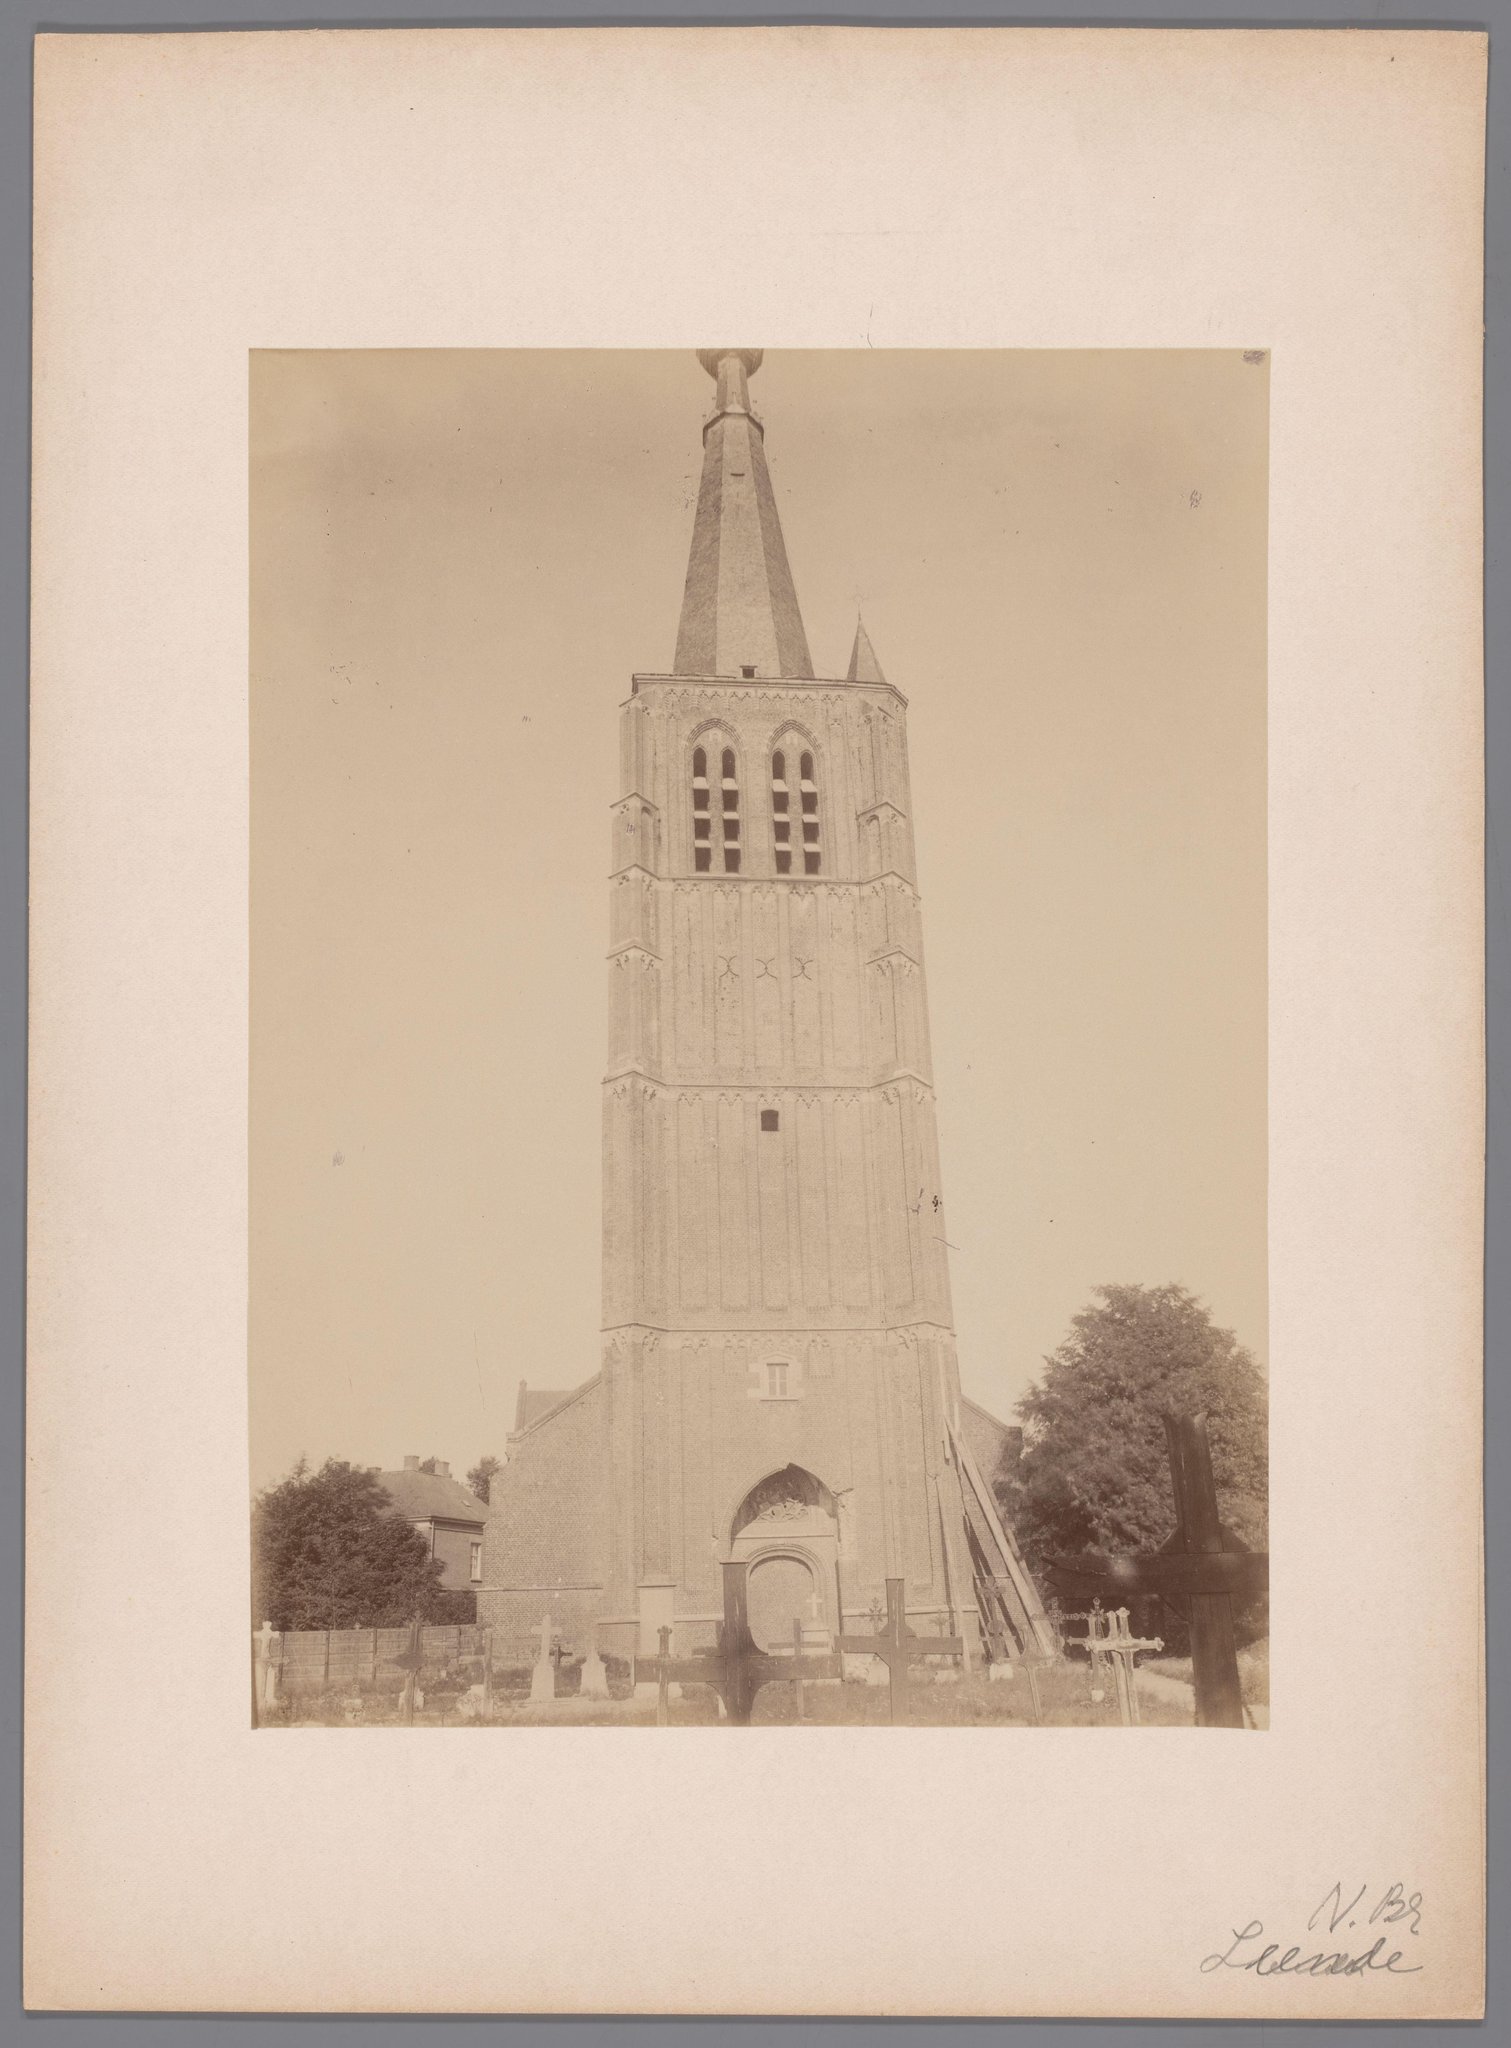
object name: photograph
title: Gezicht op de toren en de begraafplaats van de Sint-Petrus'-Bandenkerk te Leende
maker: anoniem (monumentenzorg)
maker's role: fotograaf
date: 1904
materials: cardboard, photographic support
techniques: albumen print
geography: leende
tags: churchyard, cemetery, parts of church exterior and annexes: tower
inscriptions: annotation: ‘N.Br./ Leende’, annotation: ‘Leende (N.B.)/ R.K. Kerk/ Juli 1904’